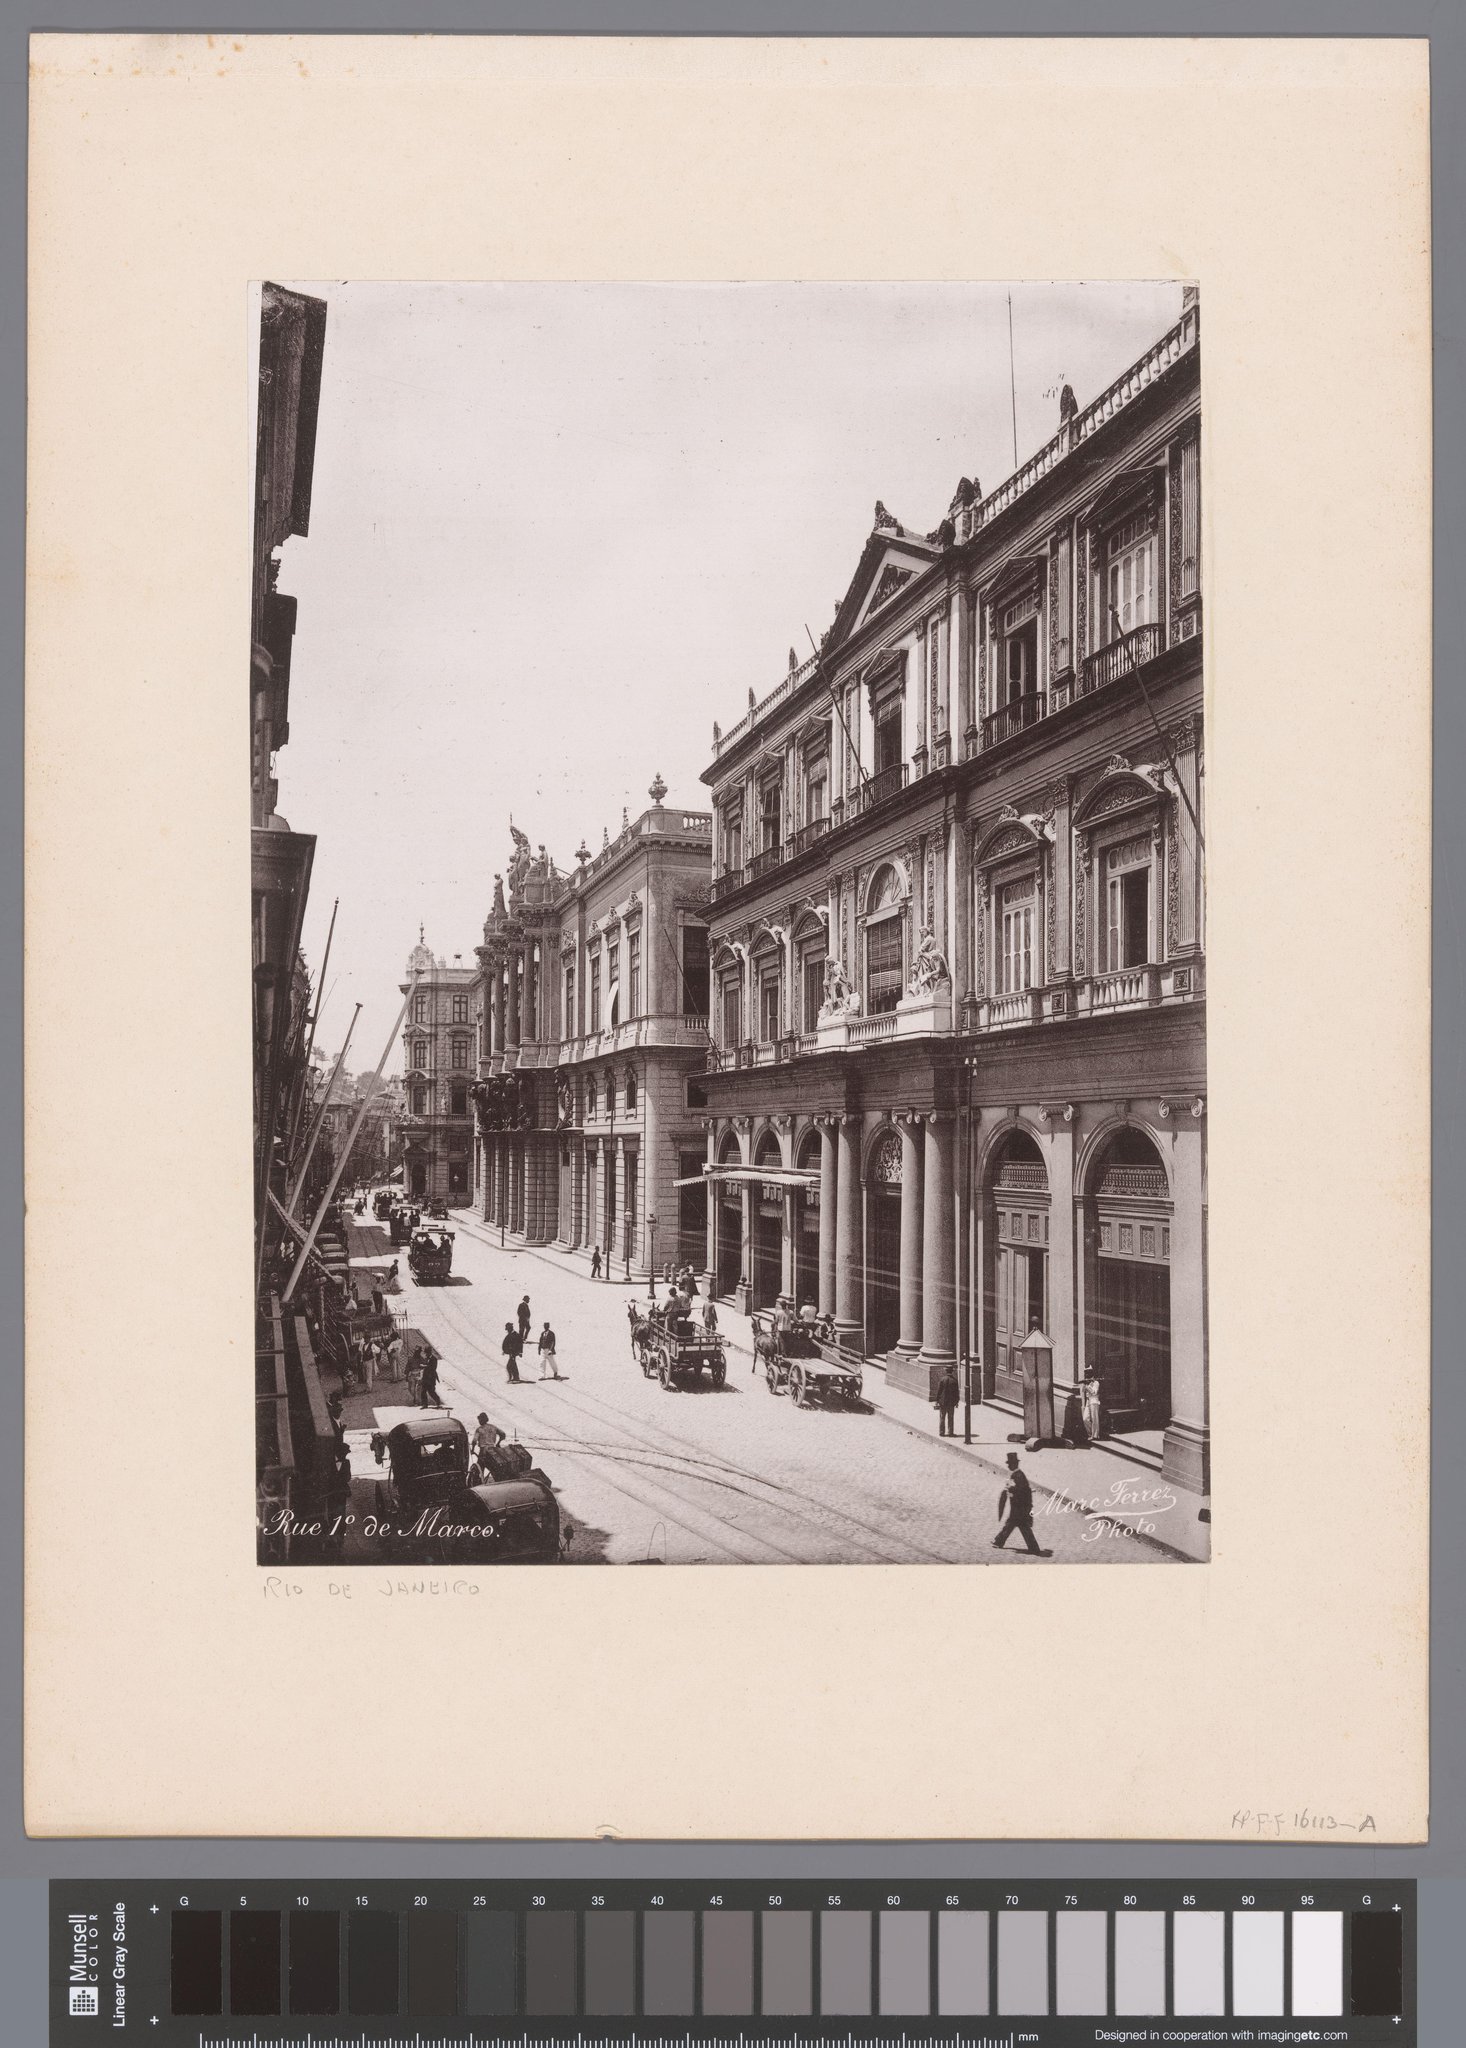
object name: photomechanical print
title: Rue 1e de Marco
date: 1890-1910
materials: cardboard, paper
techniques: photograph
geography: rio de janeiro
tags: city-view, and landscape with man-made constructions